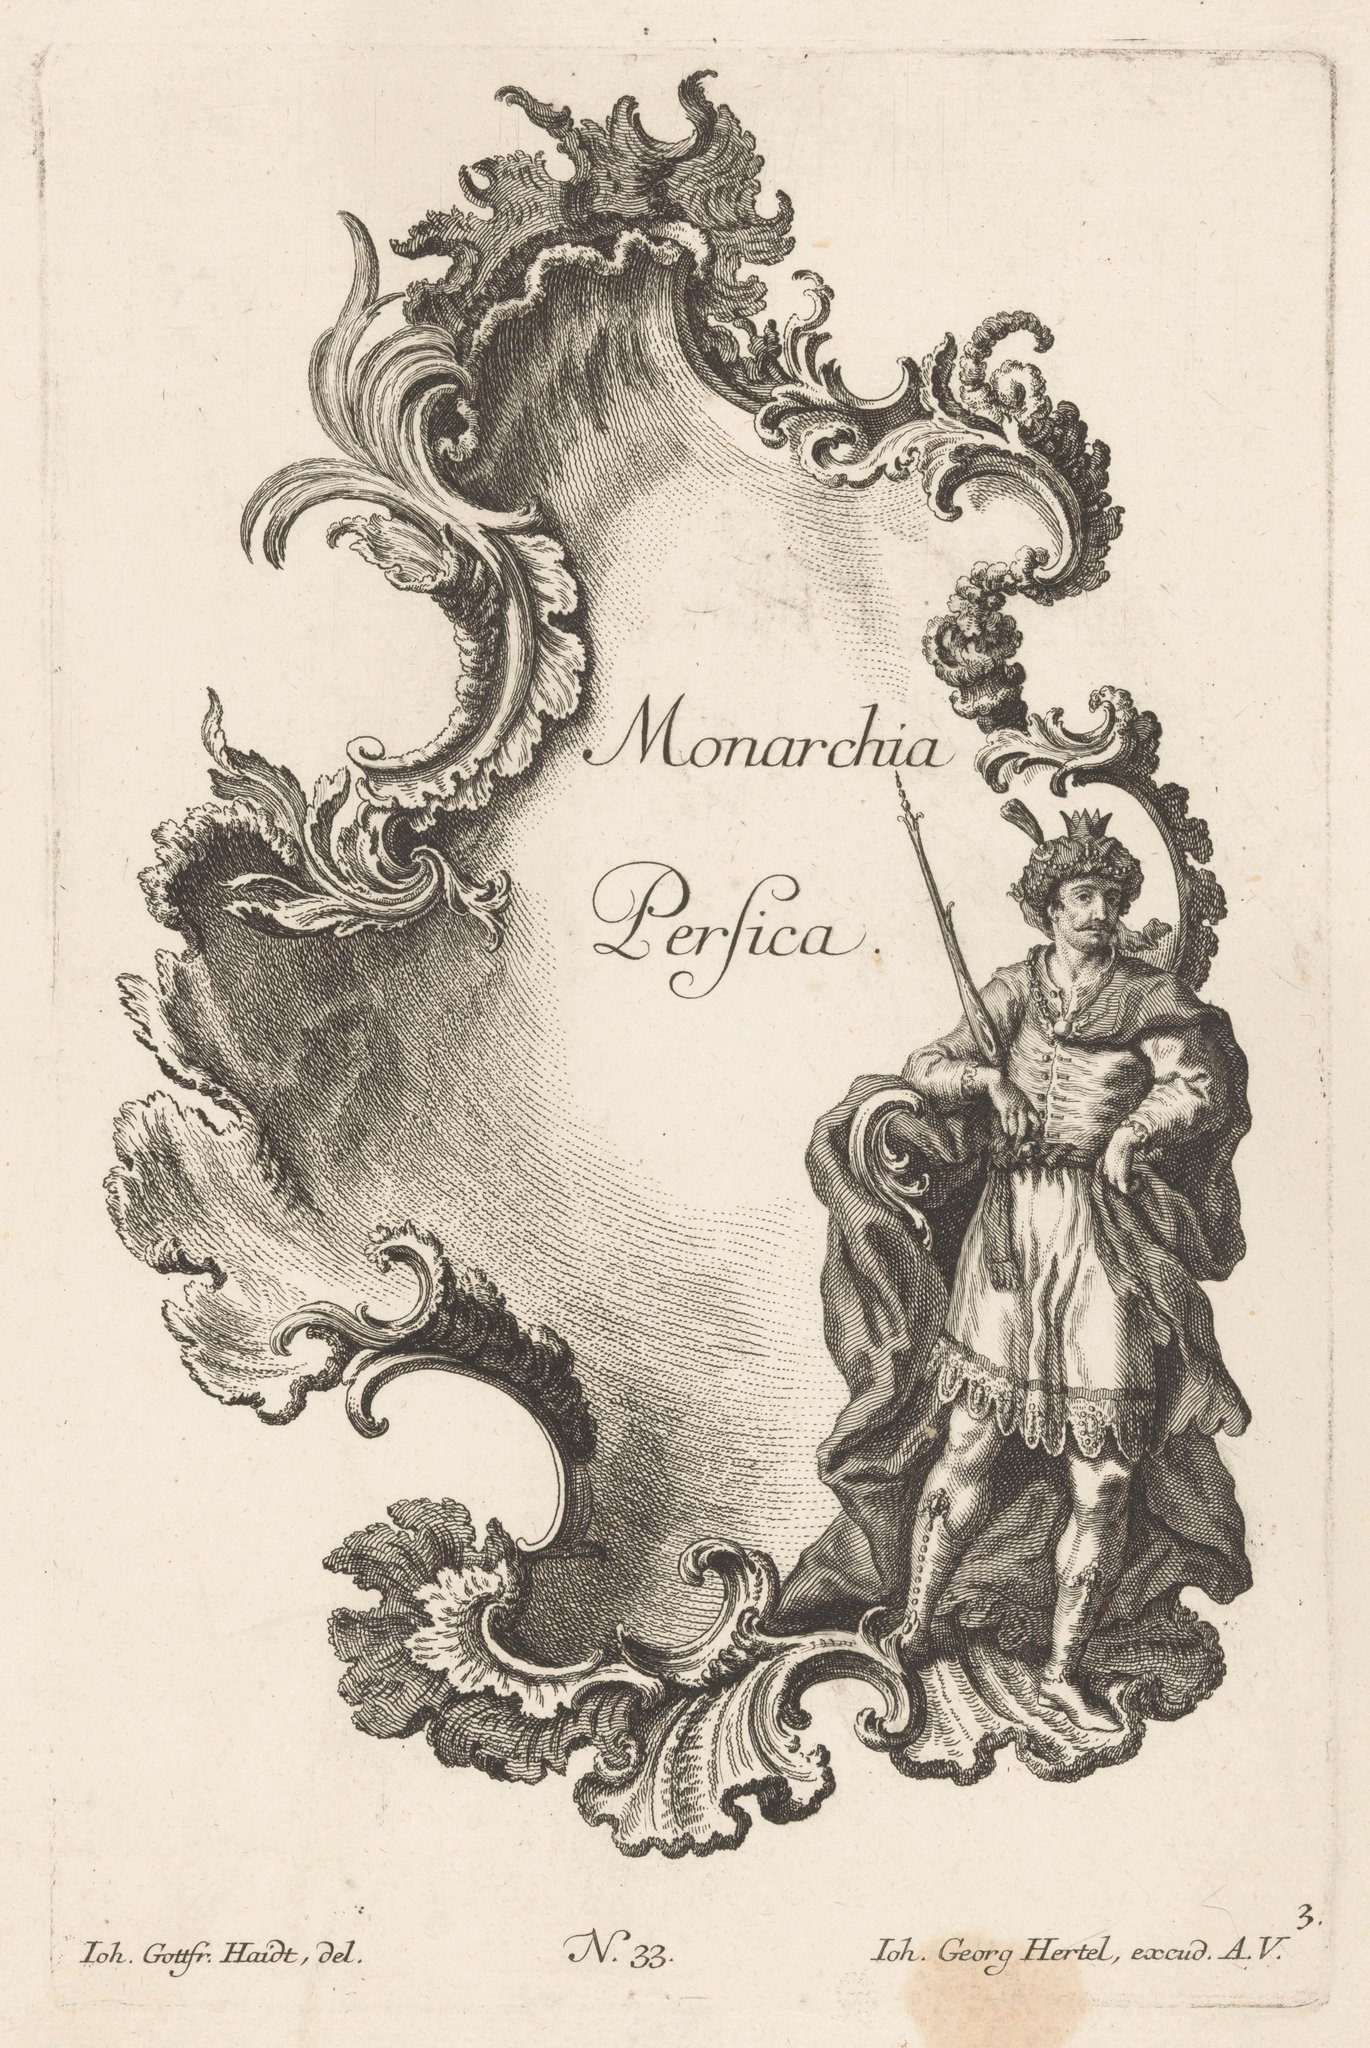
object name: print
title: Monarchia Persica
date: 1745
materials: paper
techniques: etching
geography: augsburg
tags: persia (one of the four world empires)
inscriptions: collector's mark: Lugt 2228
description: Personificatie van het Perzische Rijk in een rocaille cartouche. Rechts staat een oosters uitziende man met kroon en tulband, in zijn rechterhand houdt hij een scepter. Uitgeversnummer 33.